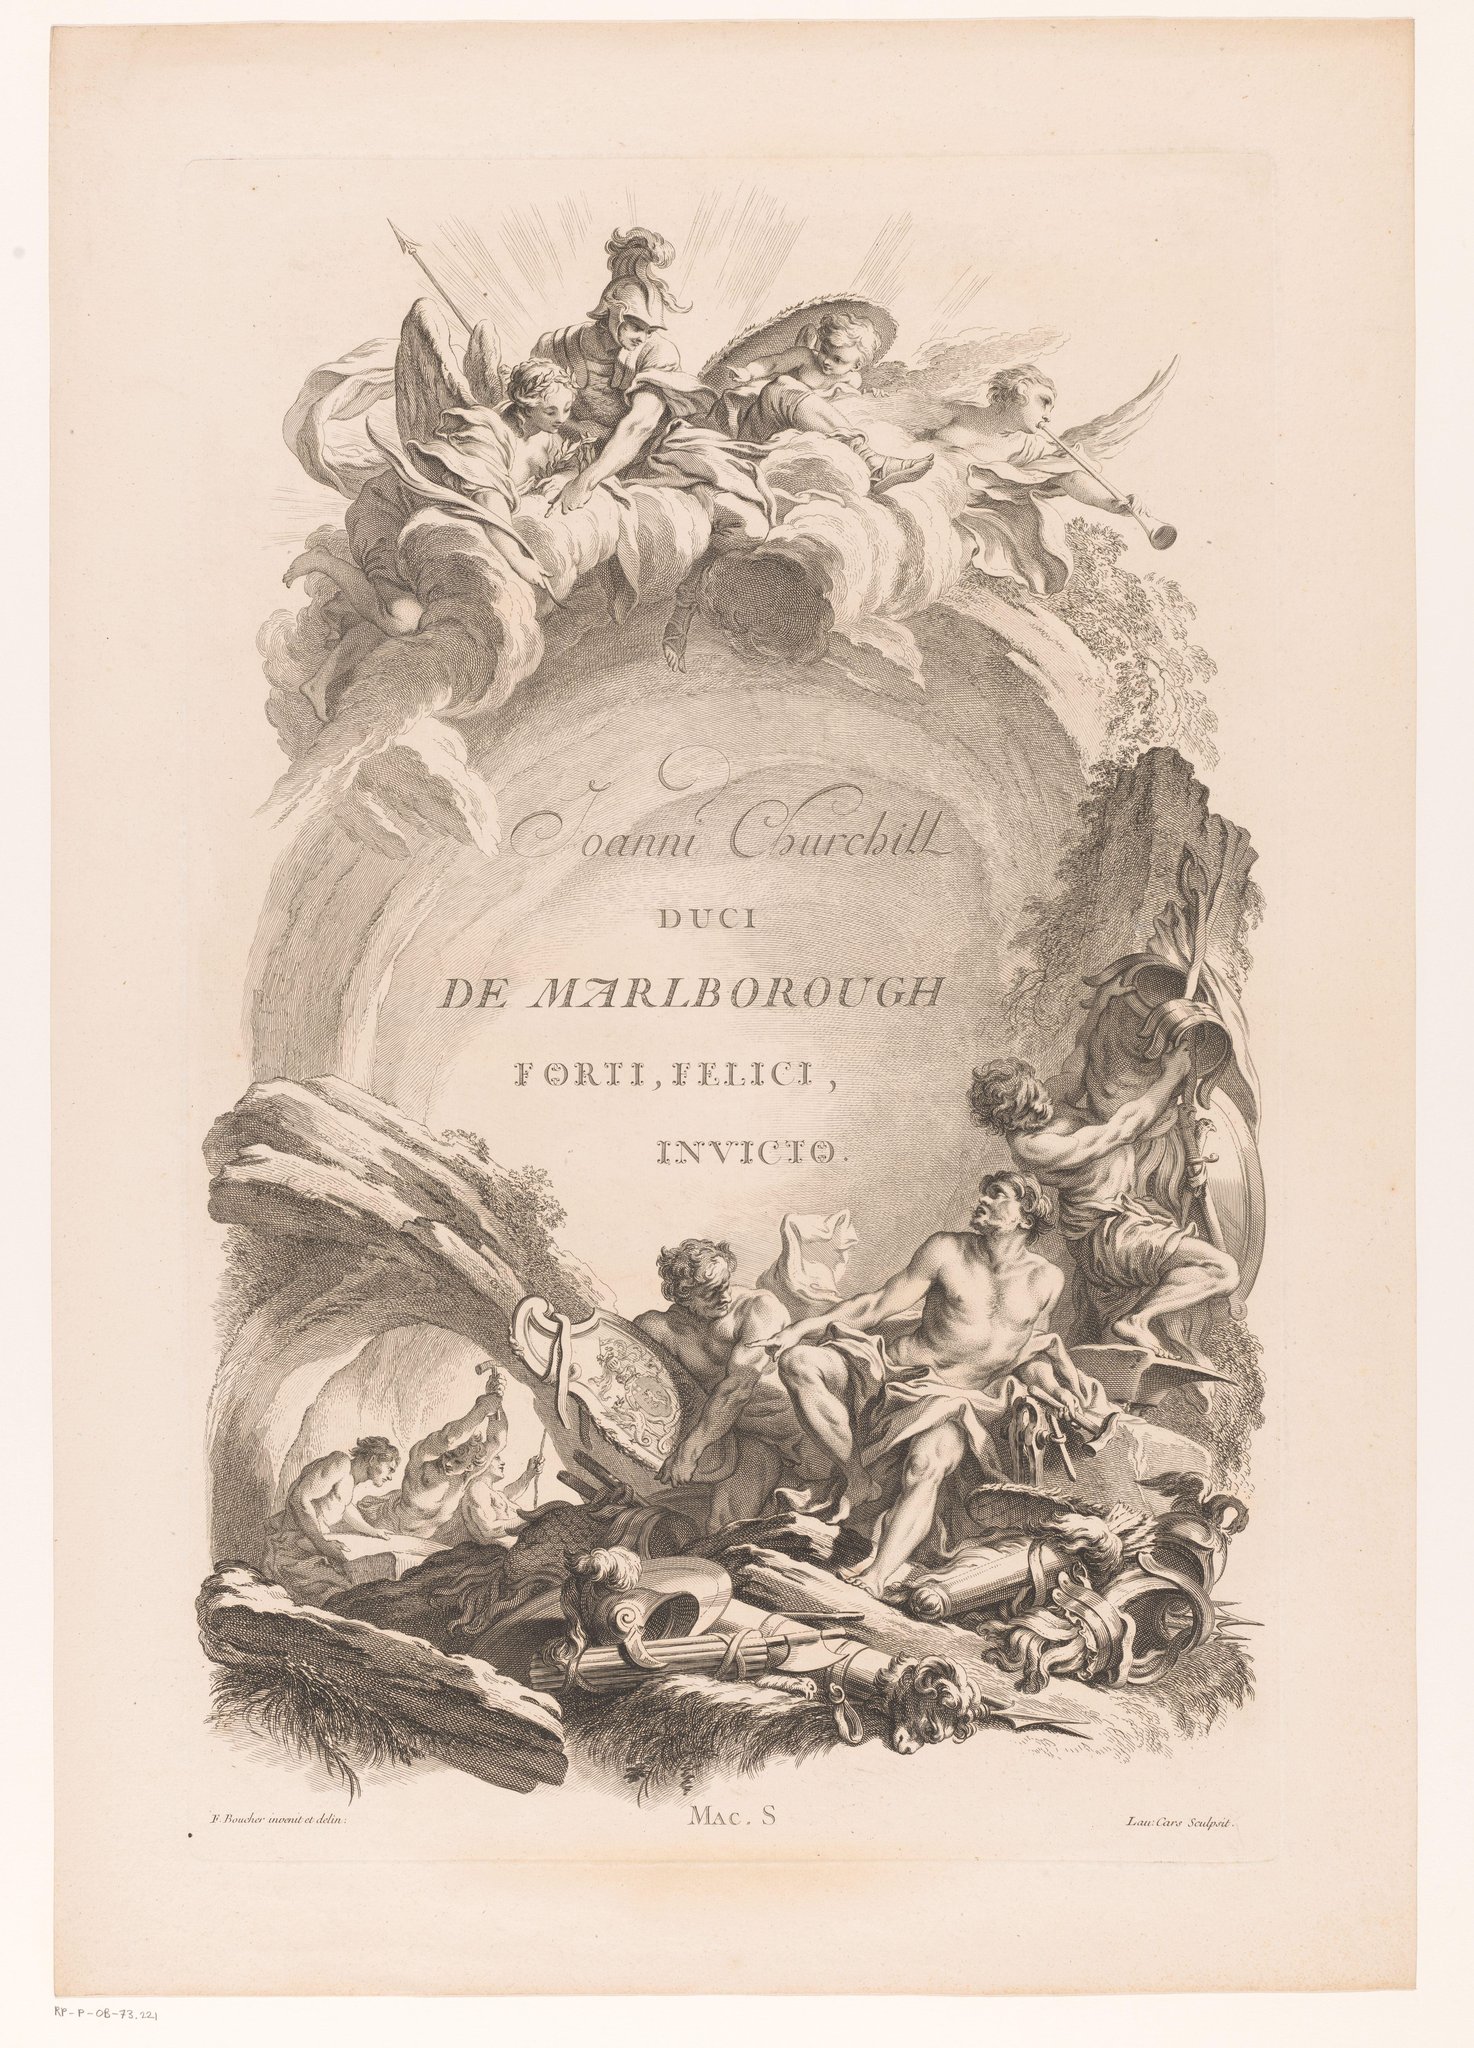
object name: print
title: Allegorie op John Churchill, 1st Duke of Marlborough met Vulcanus en Mars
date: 1735-1741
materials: paper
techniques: engraving, etching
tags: john churchill (1e hertog van marlborough), (story of) mars (ares), (story of) vulcan (hephaestus), armour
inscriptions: collector's mark: Lugt 2228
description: Maakt deel uit van een twintigdelige serie met prenten van grafmonumenten van illustere Britten naar schilderijen uit de collectie van de Duke of Richmond. De serie bestaat uit prenten door verschillende kunstenaars en werd eerst uitgegeven door Mac Swiny en daarna door Basan. Dit betreft de prent voorafgaand aan het allegorisch grafmonument voor John Churchill, 1st Duke of Marlborough.